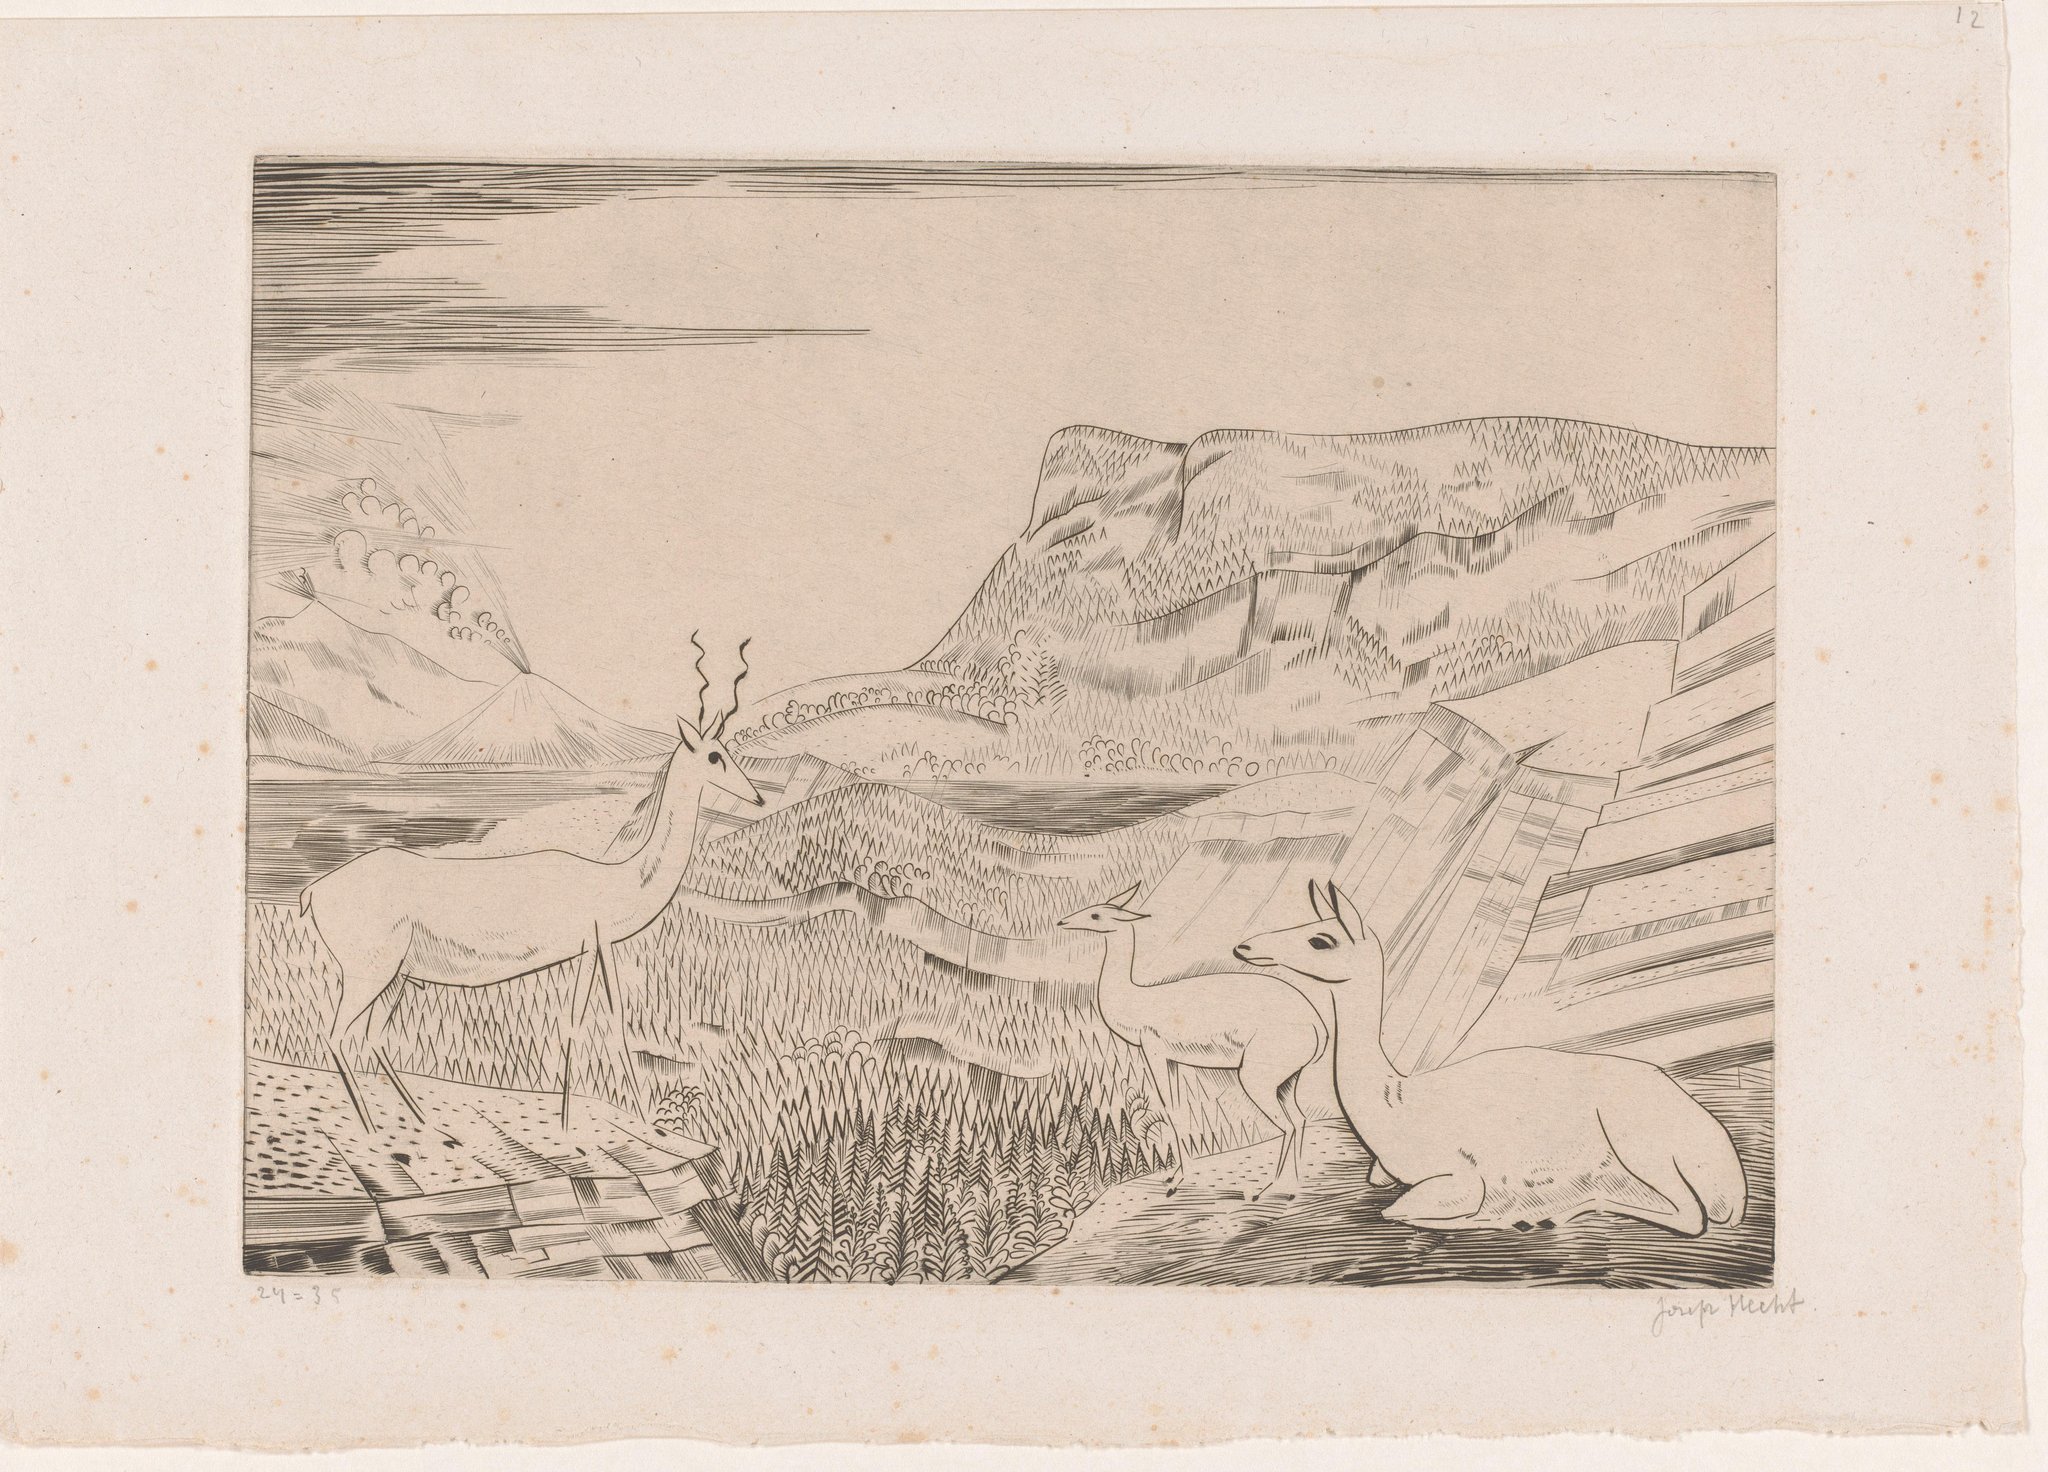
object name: print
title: Antilopen in berglandschap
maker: joseph hecht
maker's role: print maker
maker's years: 1891-1951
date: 1920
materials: paper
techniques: engraving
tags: hoofed animals: antelope, mountains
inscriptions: collector's mark: Lugt 2228